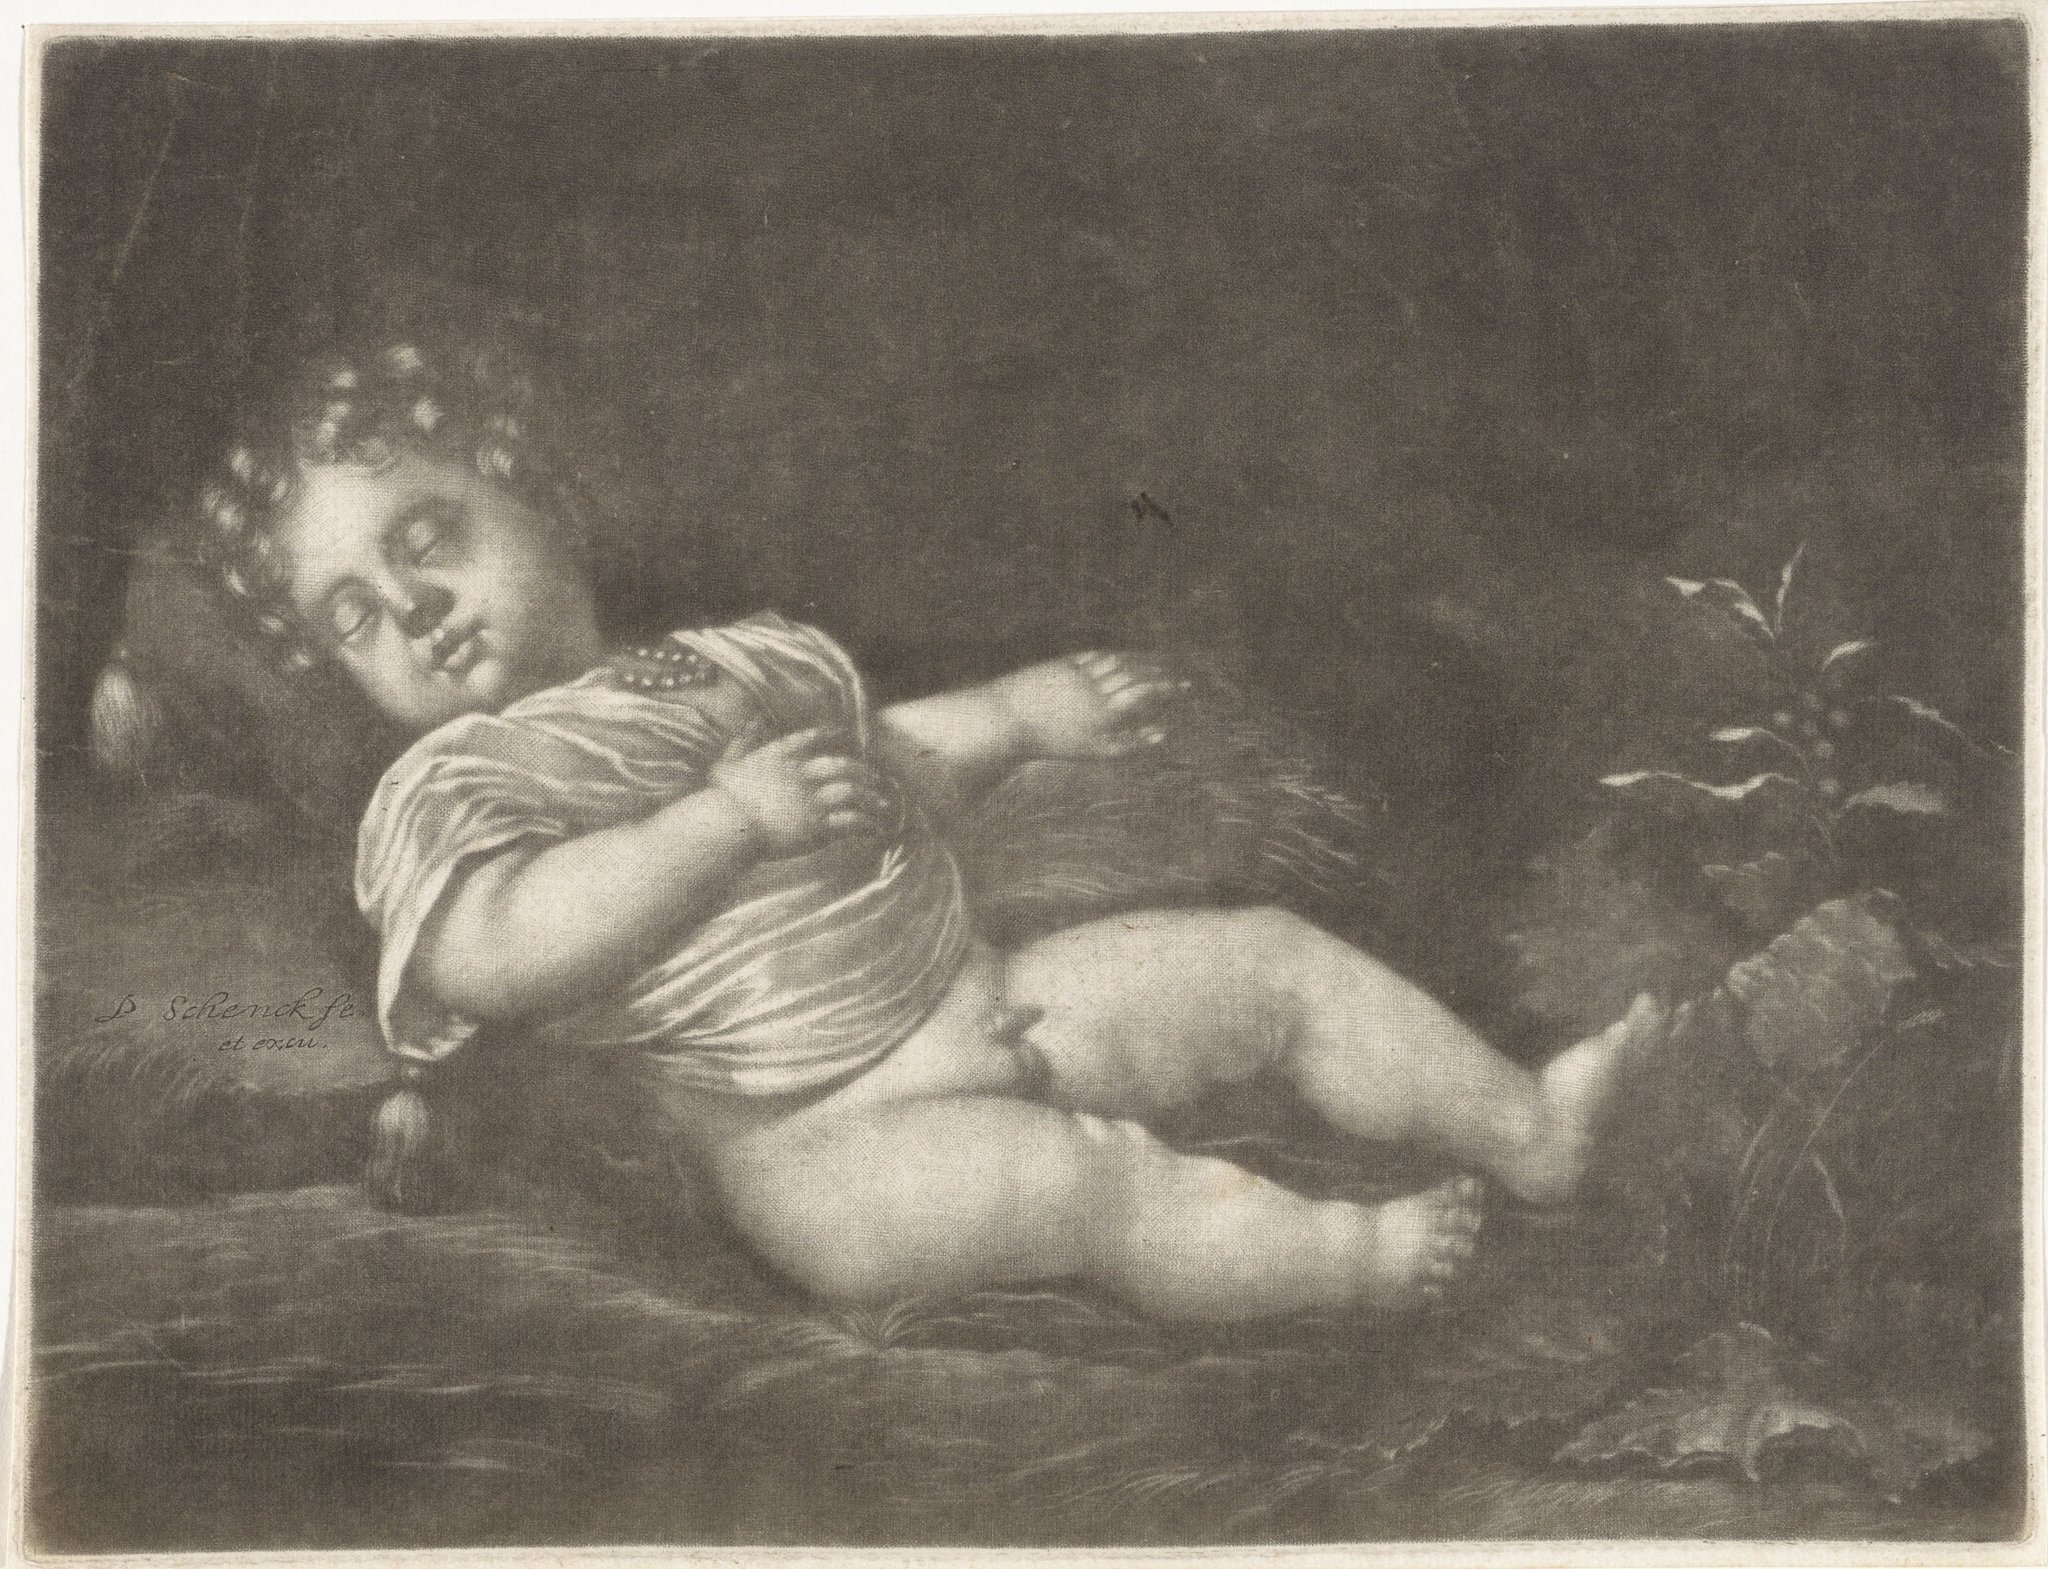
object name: print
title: Slapend jongetje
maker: pieter schenk (i)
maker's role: print maker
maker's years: 1660-1711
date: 1670-1713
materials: paper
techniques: engraving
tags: sleeping on the ground - bb - out of doors, necklace (+ women's clothes)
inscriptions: collector's mark: Lugt 2228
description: Een half naakt jongetje ligt op de grond te slapen tussen het struikgewas. Zijn hoofd rust op een kussen en hij draagt een parelsnoer.